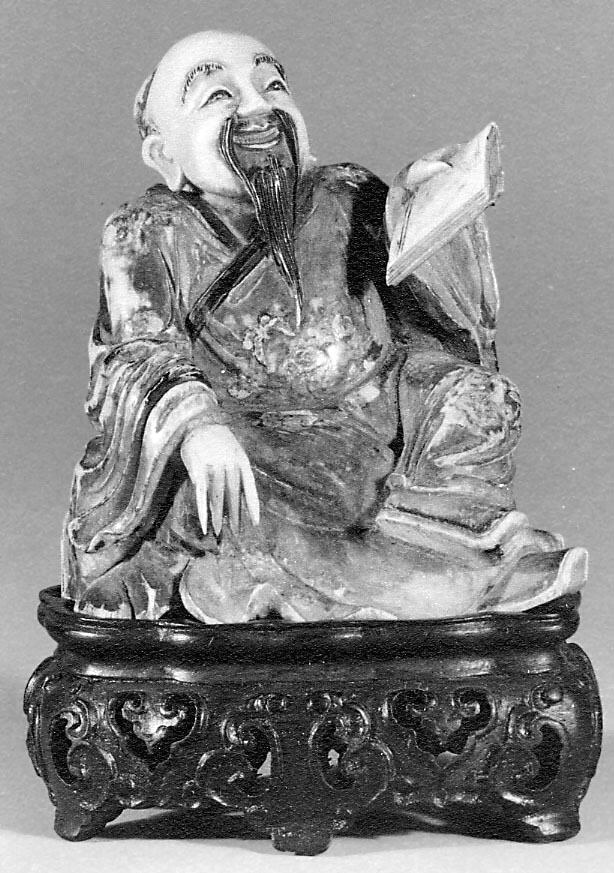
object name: statuette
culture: chinese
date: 1867-1900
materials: ivory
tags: men